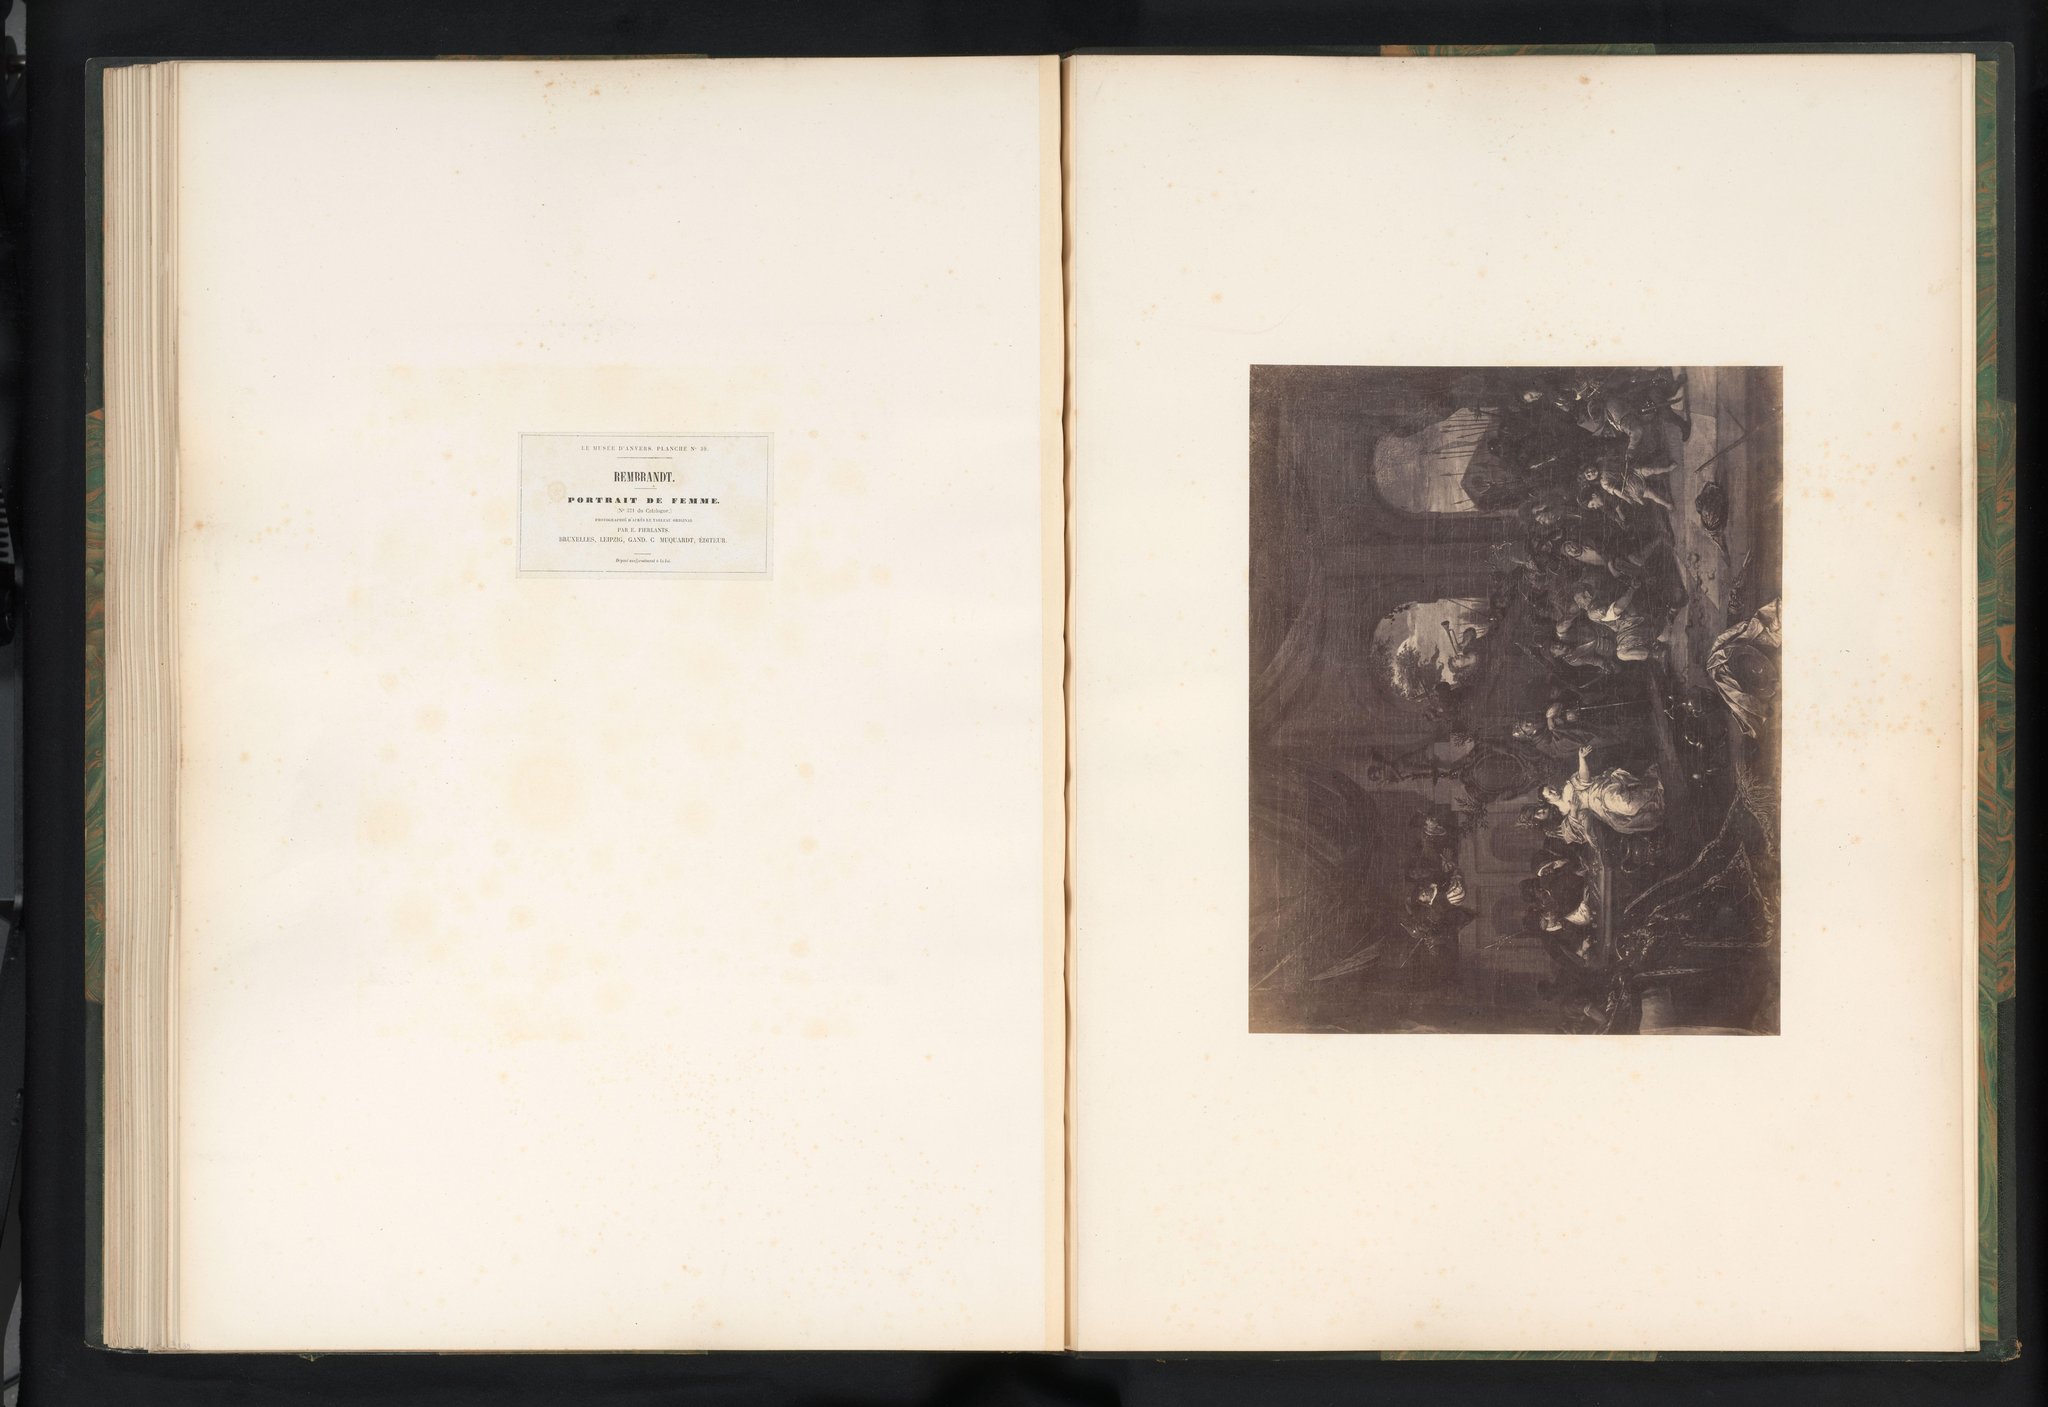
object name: photograph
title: Fotoreproductie van Simson beledigd door de Filistijnen door Jan Havicksz. Steen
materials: photographic support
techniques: albumen print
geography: brussels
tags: samson in conflict with the philistines (judges 15:1-8)